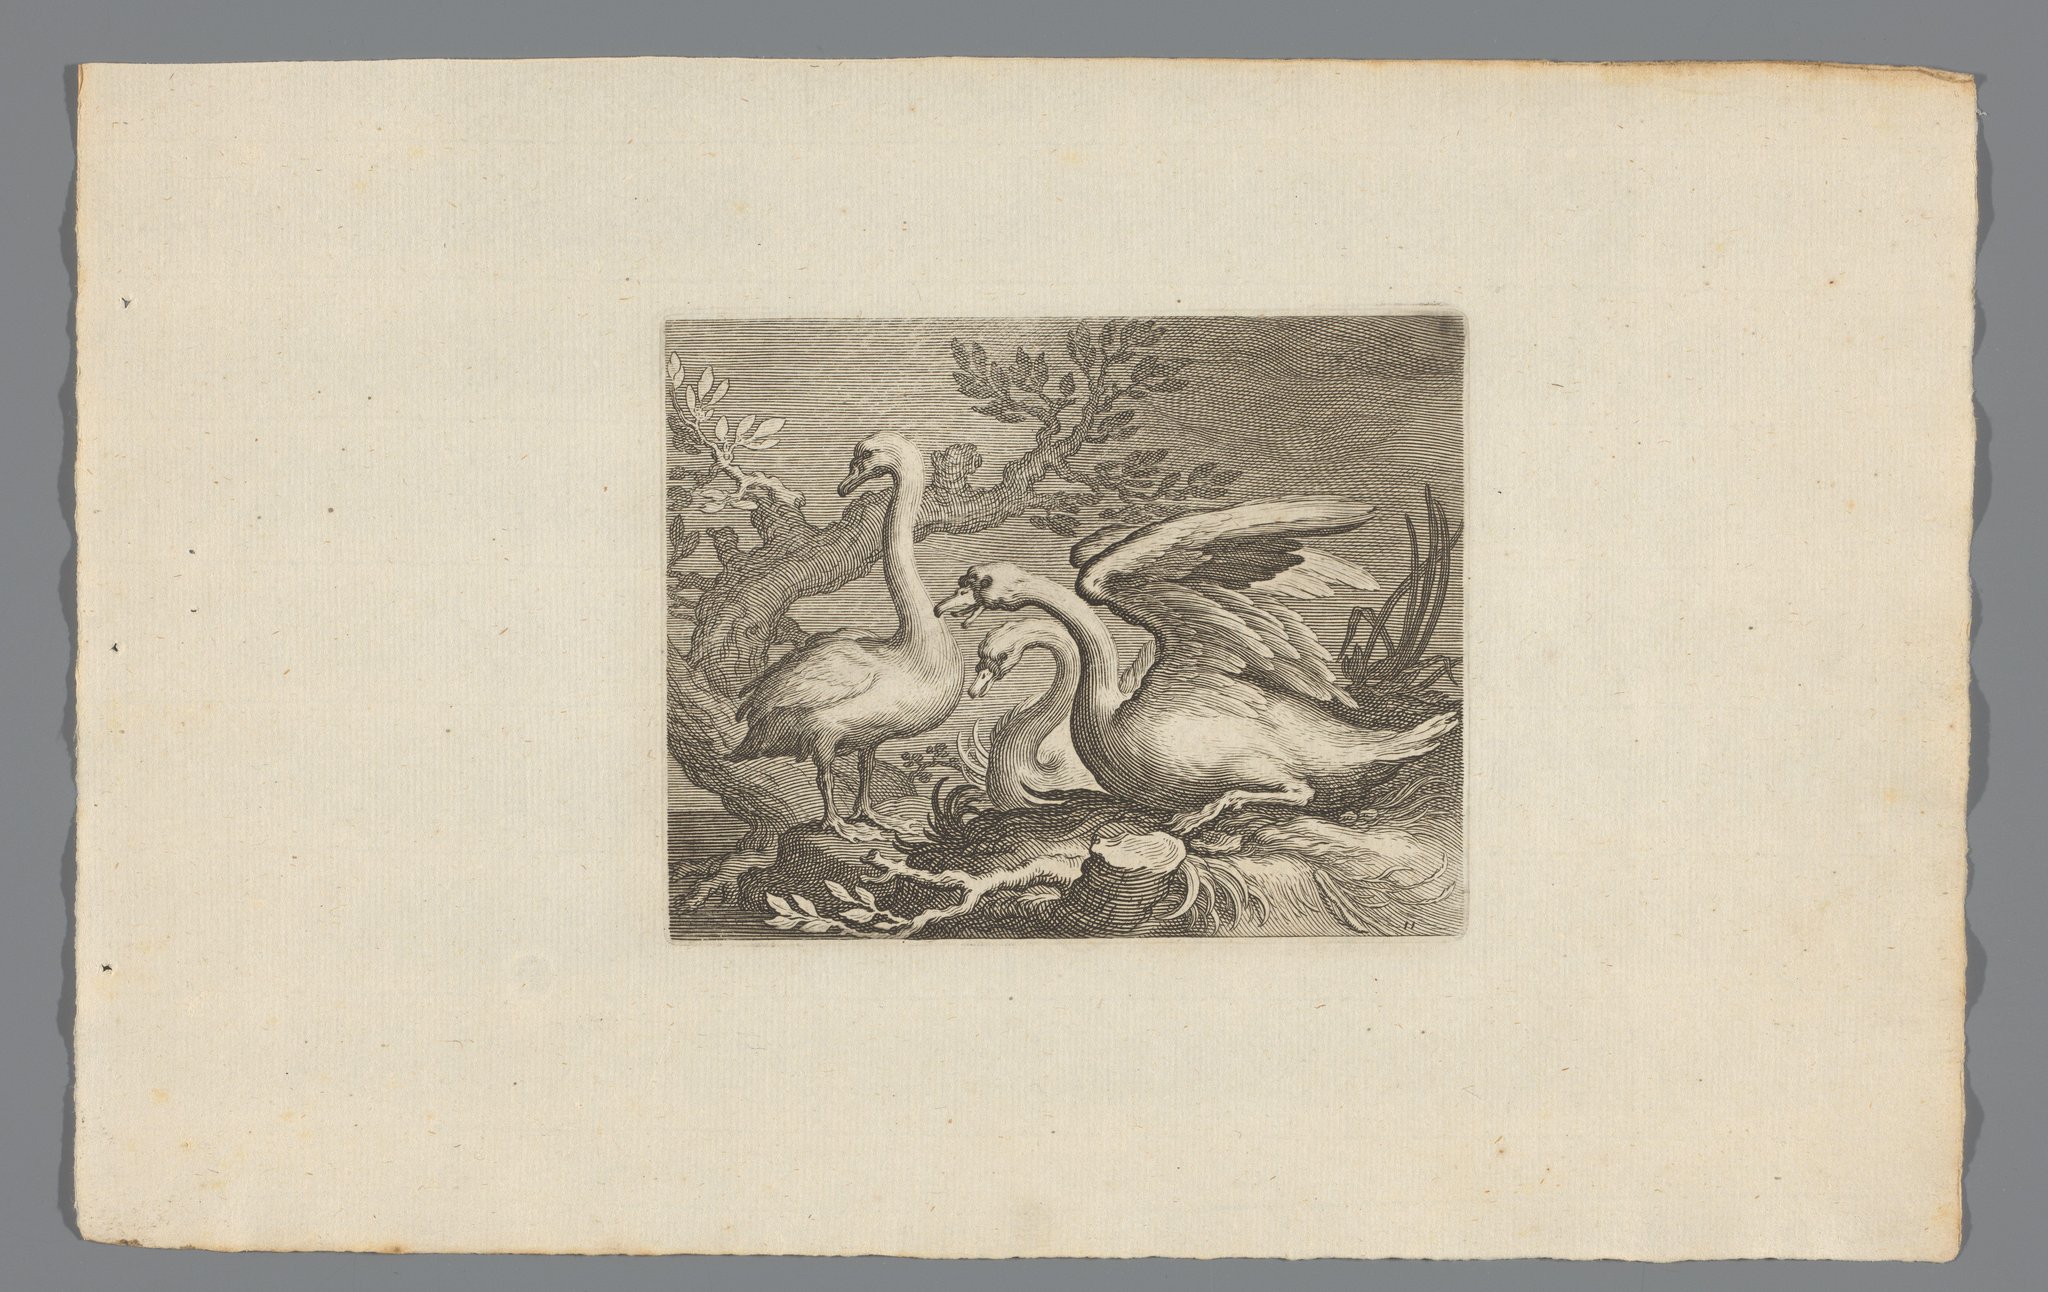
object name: print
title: Pastoralen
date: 1611-1632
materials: paper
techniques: engraving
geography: amsterdam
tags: water-birds: swan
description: Prent maakt deel uit van een serie van veertien prenten.